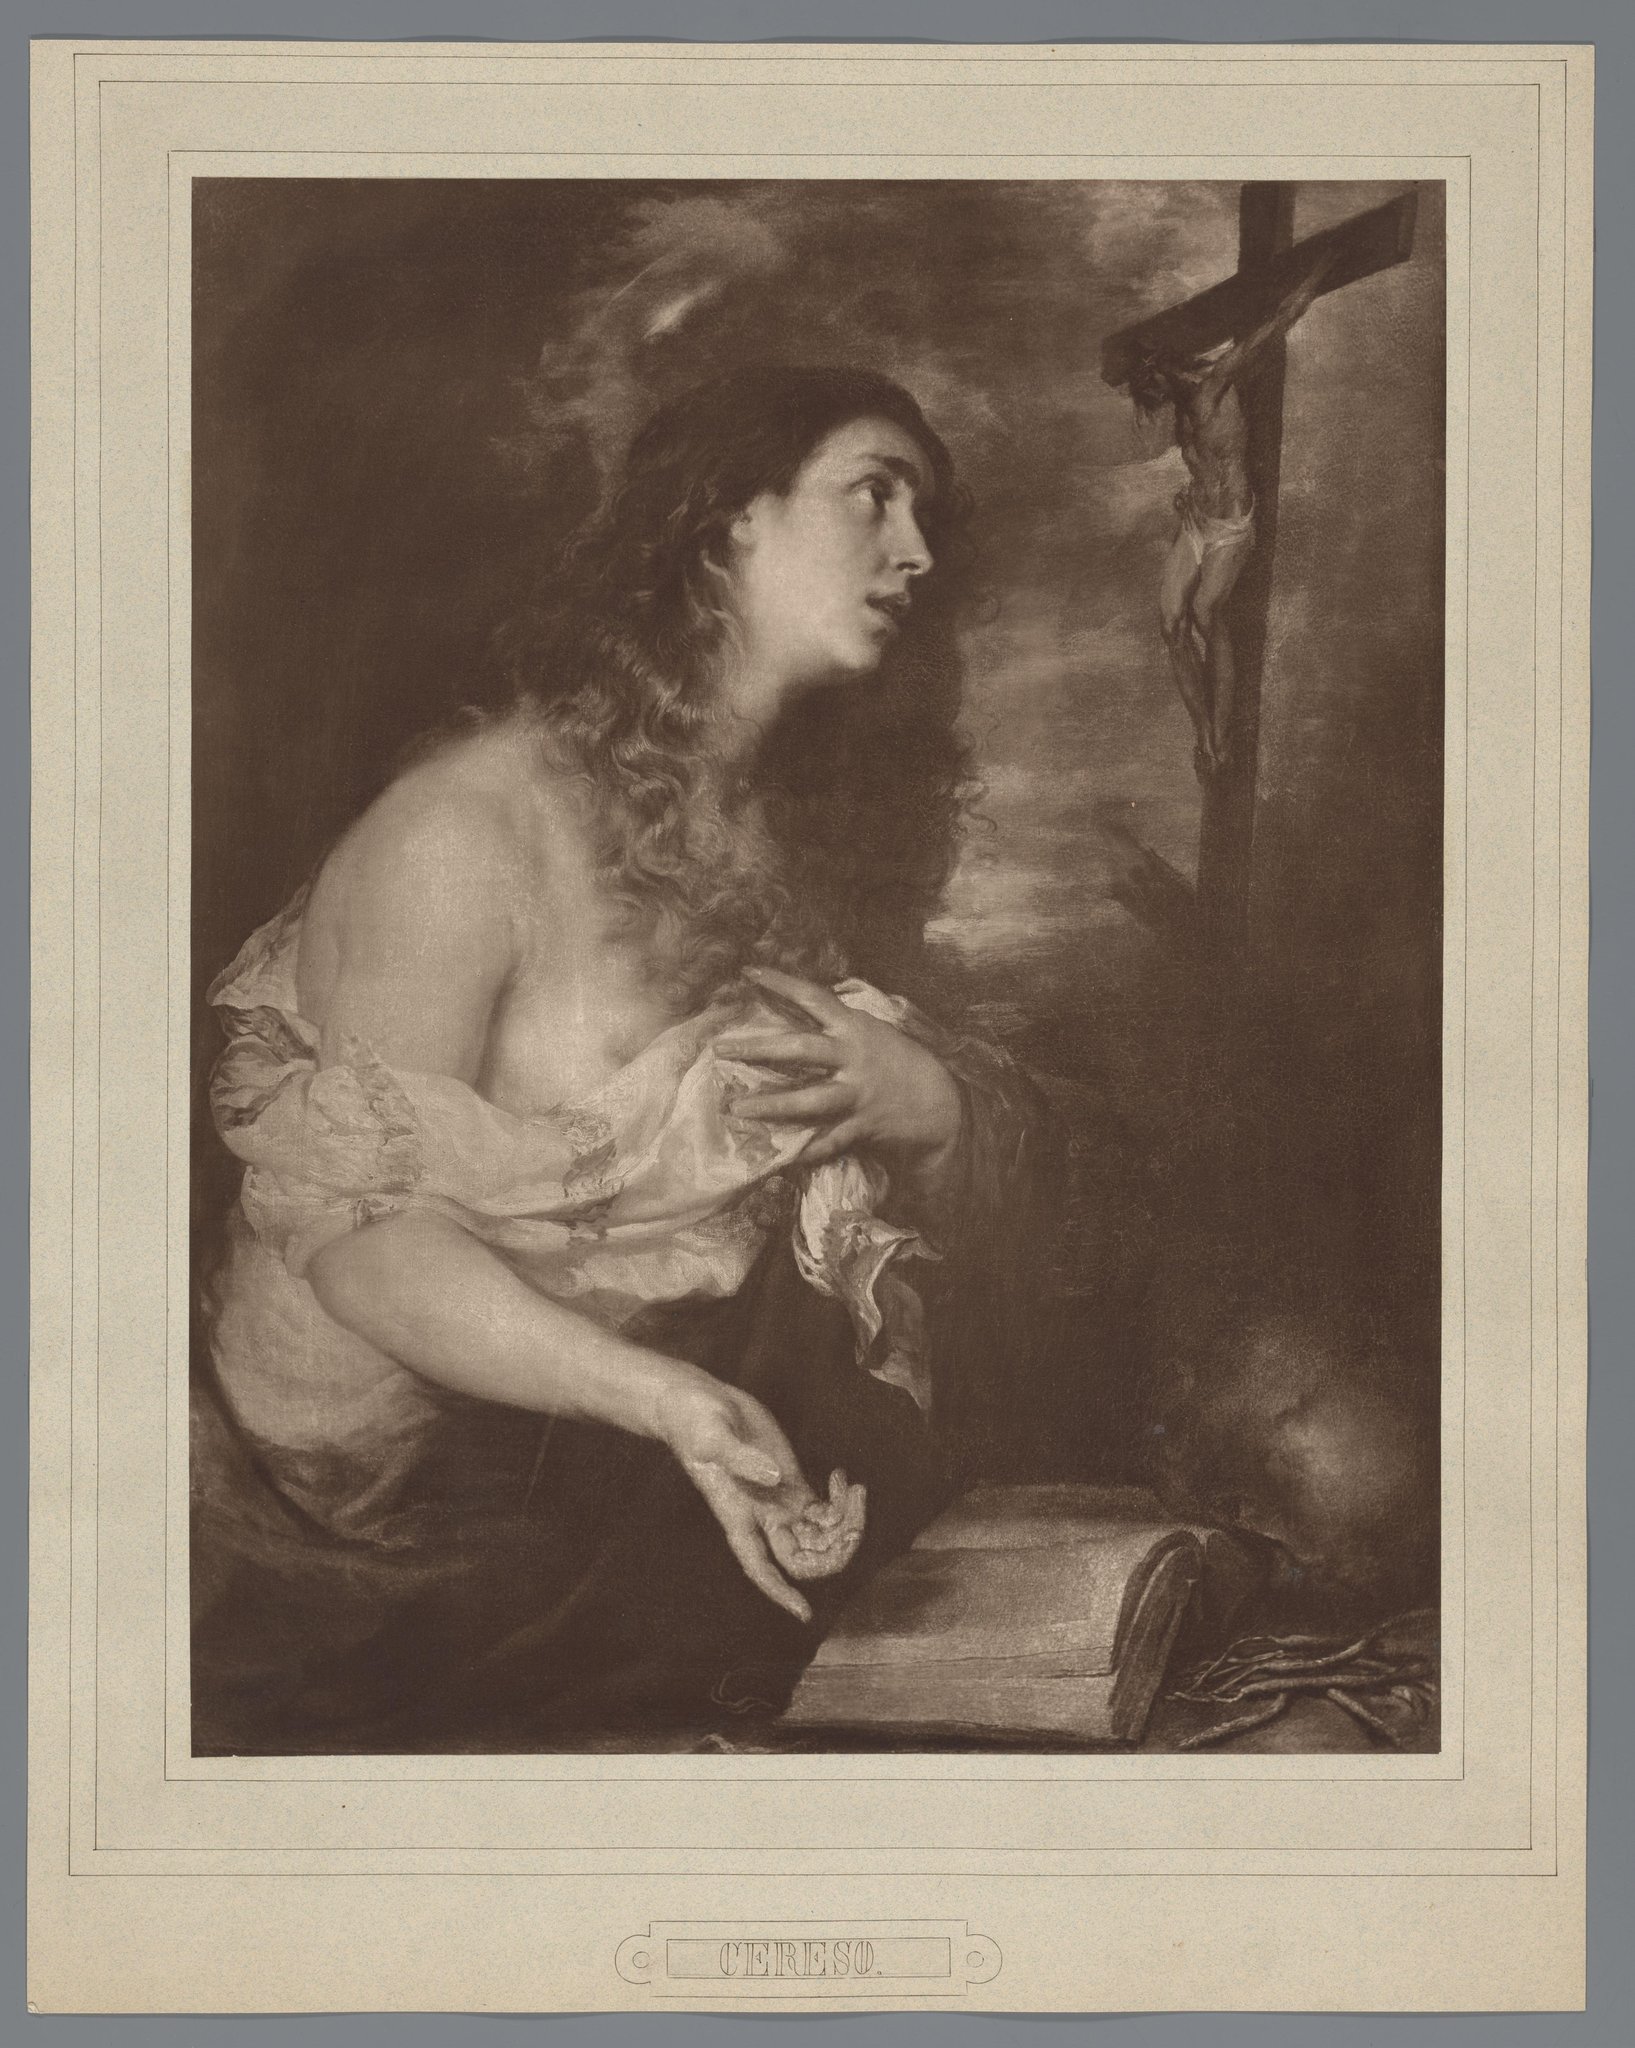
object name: photograph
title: Fotoreproductie van een schilderij van Mateo Cerezo, 'De boetvaardige Maria Magdalena' (coll. Rijksmuseum)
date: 1880-1900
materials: cardboard, paper, photographic support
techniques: carbon print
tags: the penitent st. mary magdalene (often before a cave, possibly at la sainte-baume hill): her long hair covers her (naked) body, she reads, meditates or raises her tear-filled eyes towards heaven